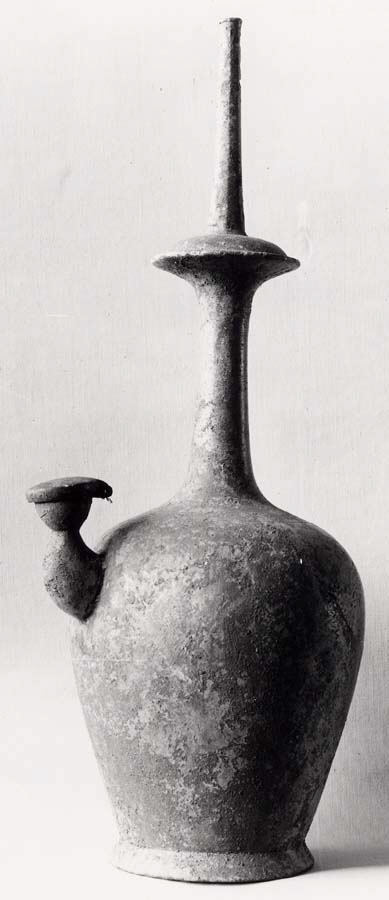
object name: vessel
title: Ceremonial Vessel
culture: korean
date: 918-1392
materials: bronze